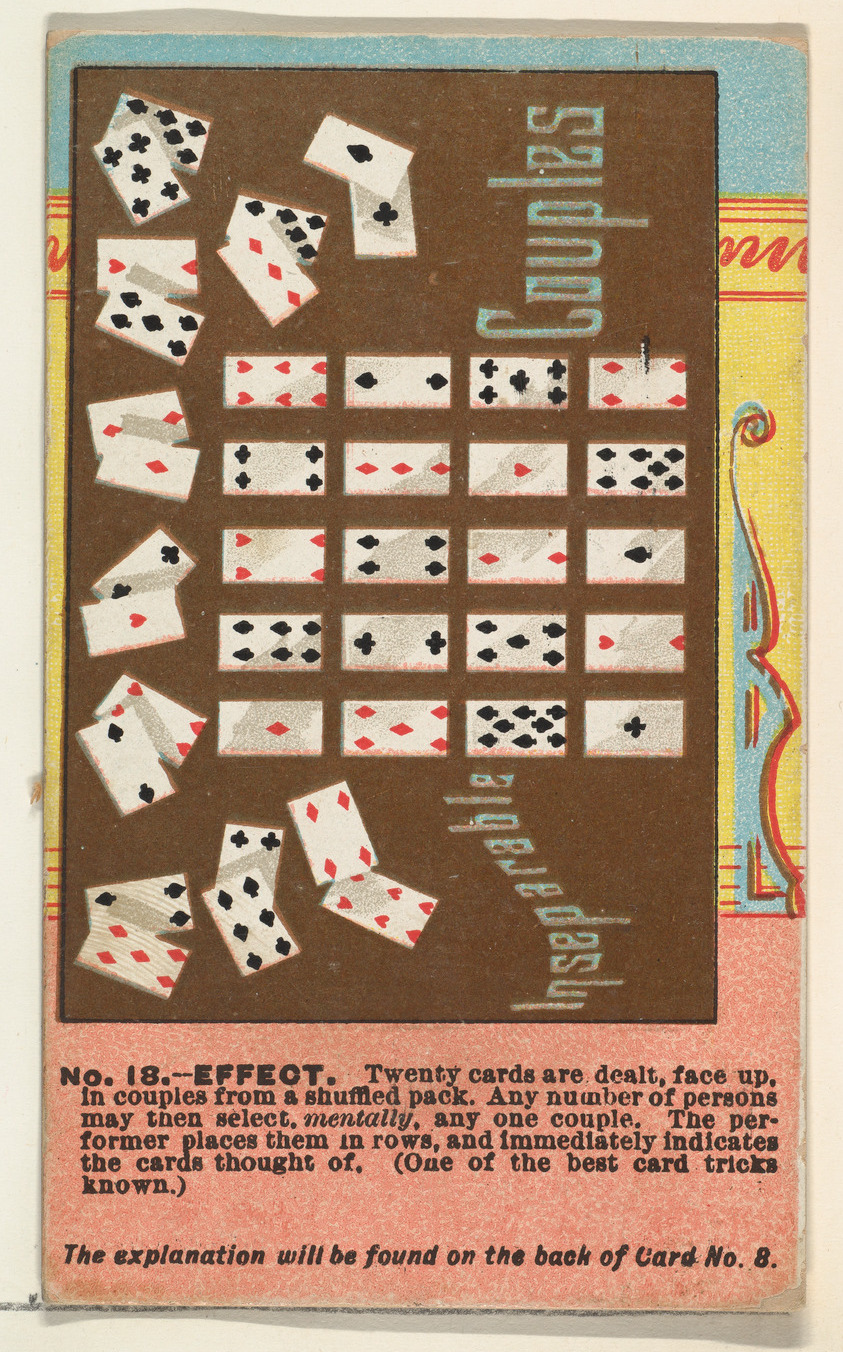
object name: print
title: Number 18, Inseparable Couples, from the Tricks with Cards series (N138) issued by W. Duke, Sons & Co. to promote Honest Long Cut Tobacco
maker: w. duke, sons & co.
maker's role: publisher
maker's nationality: american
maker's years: 1870-1920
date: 1887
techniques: color lithograph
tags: magic,playing cards